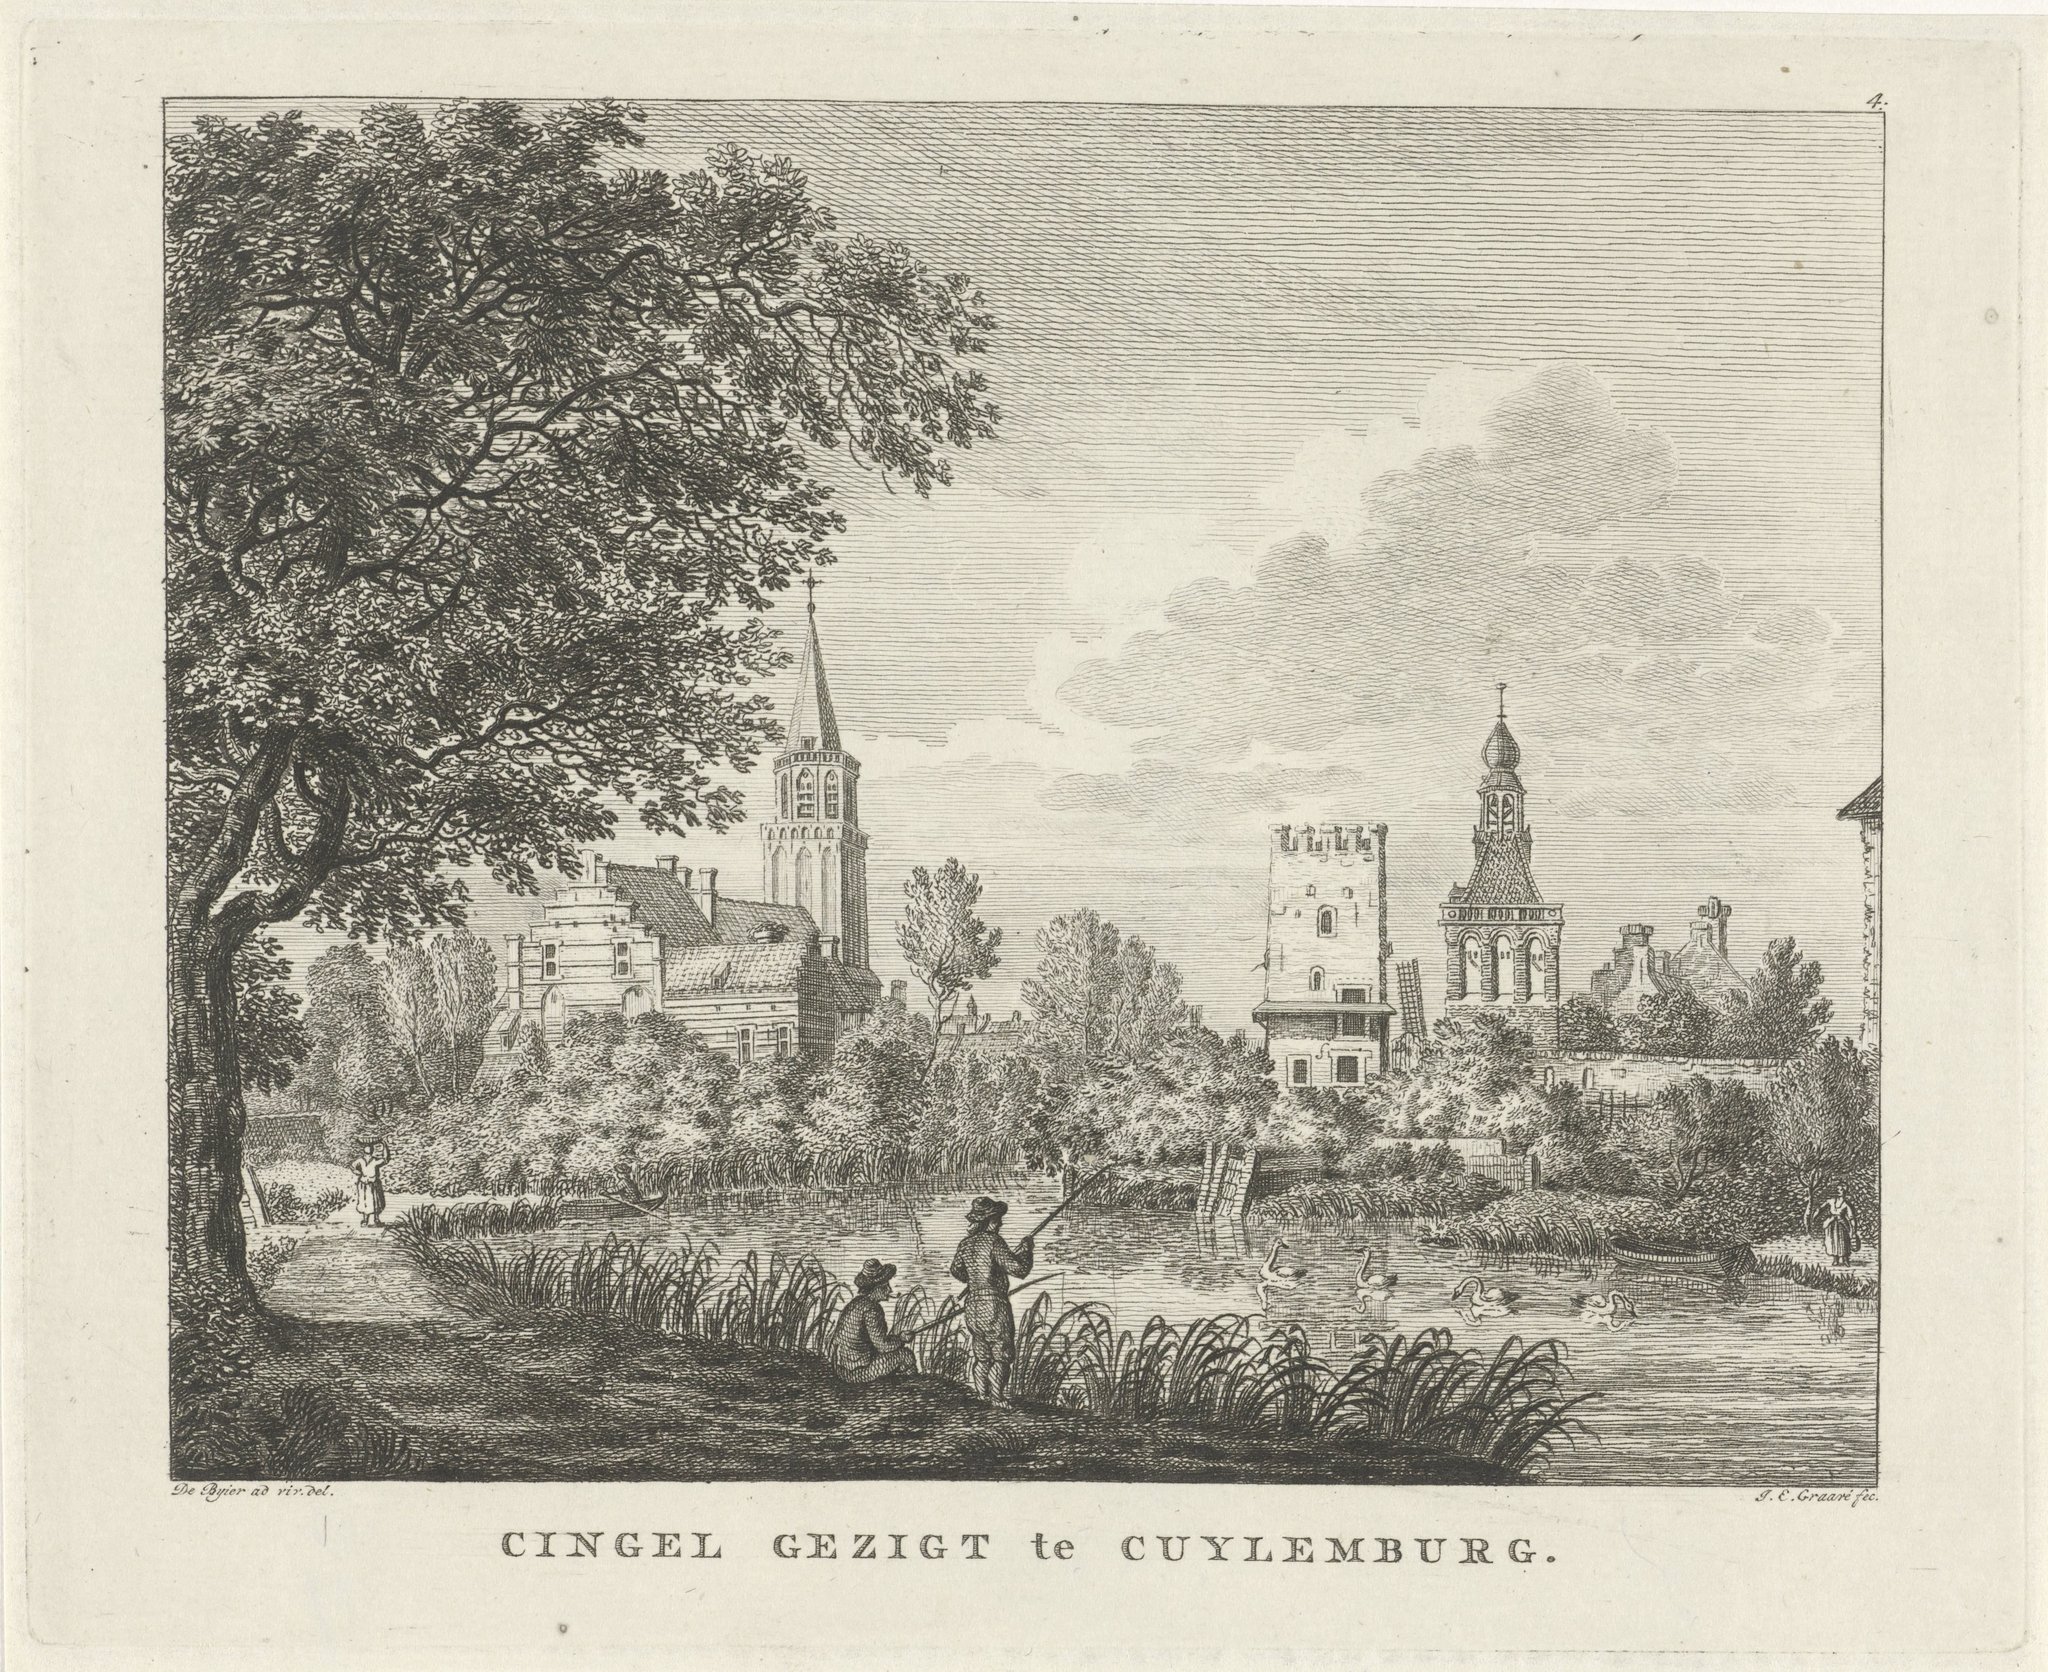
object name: print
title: Nederlandse dorpen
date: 1786-1805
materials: paper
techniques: etching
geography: amsterdam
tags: river (+ landscape with figures, staffage), fisherman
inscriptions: collector's mark: Lugt 2228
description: Het dorp Culemborg. Op de voorgrond de singel met hengelaars. Op de achtergrond de kerktoren. De prent maakt deel uit van een serie met Nederlandse dorpen.